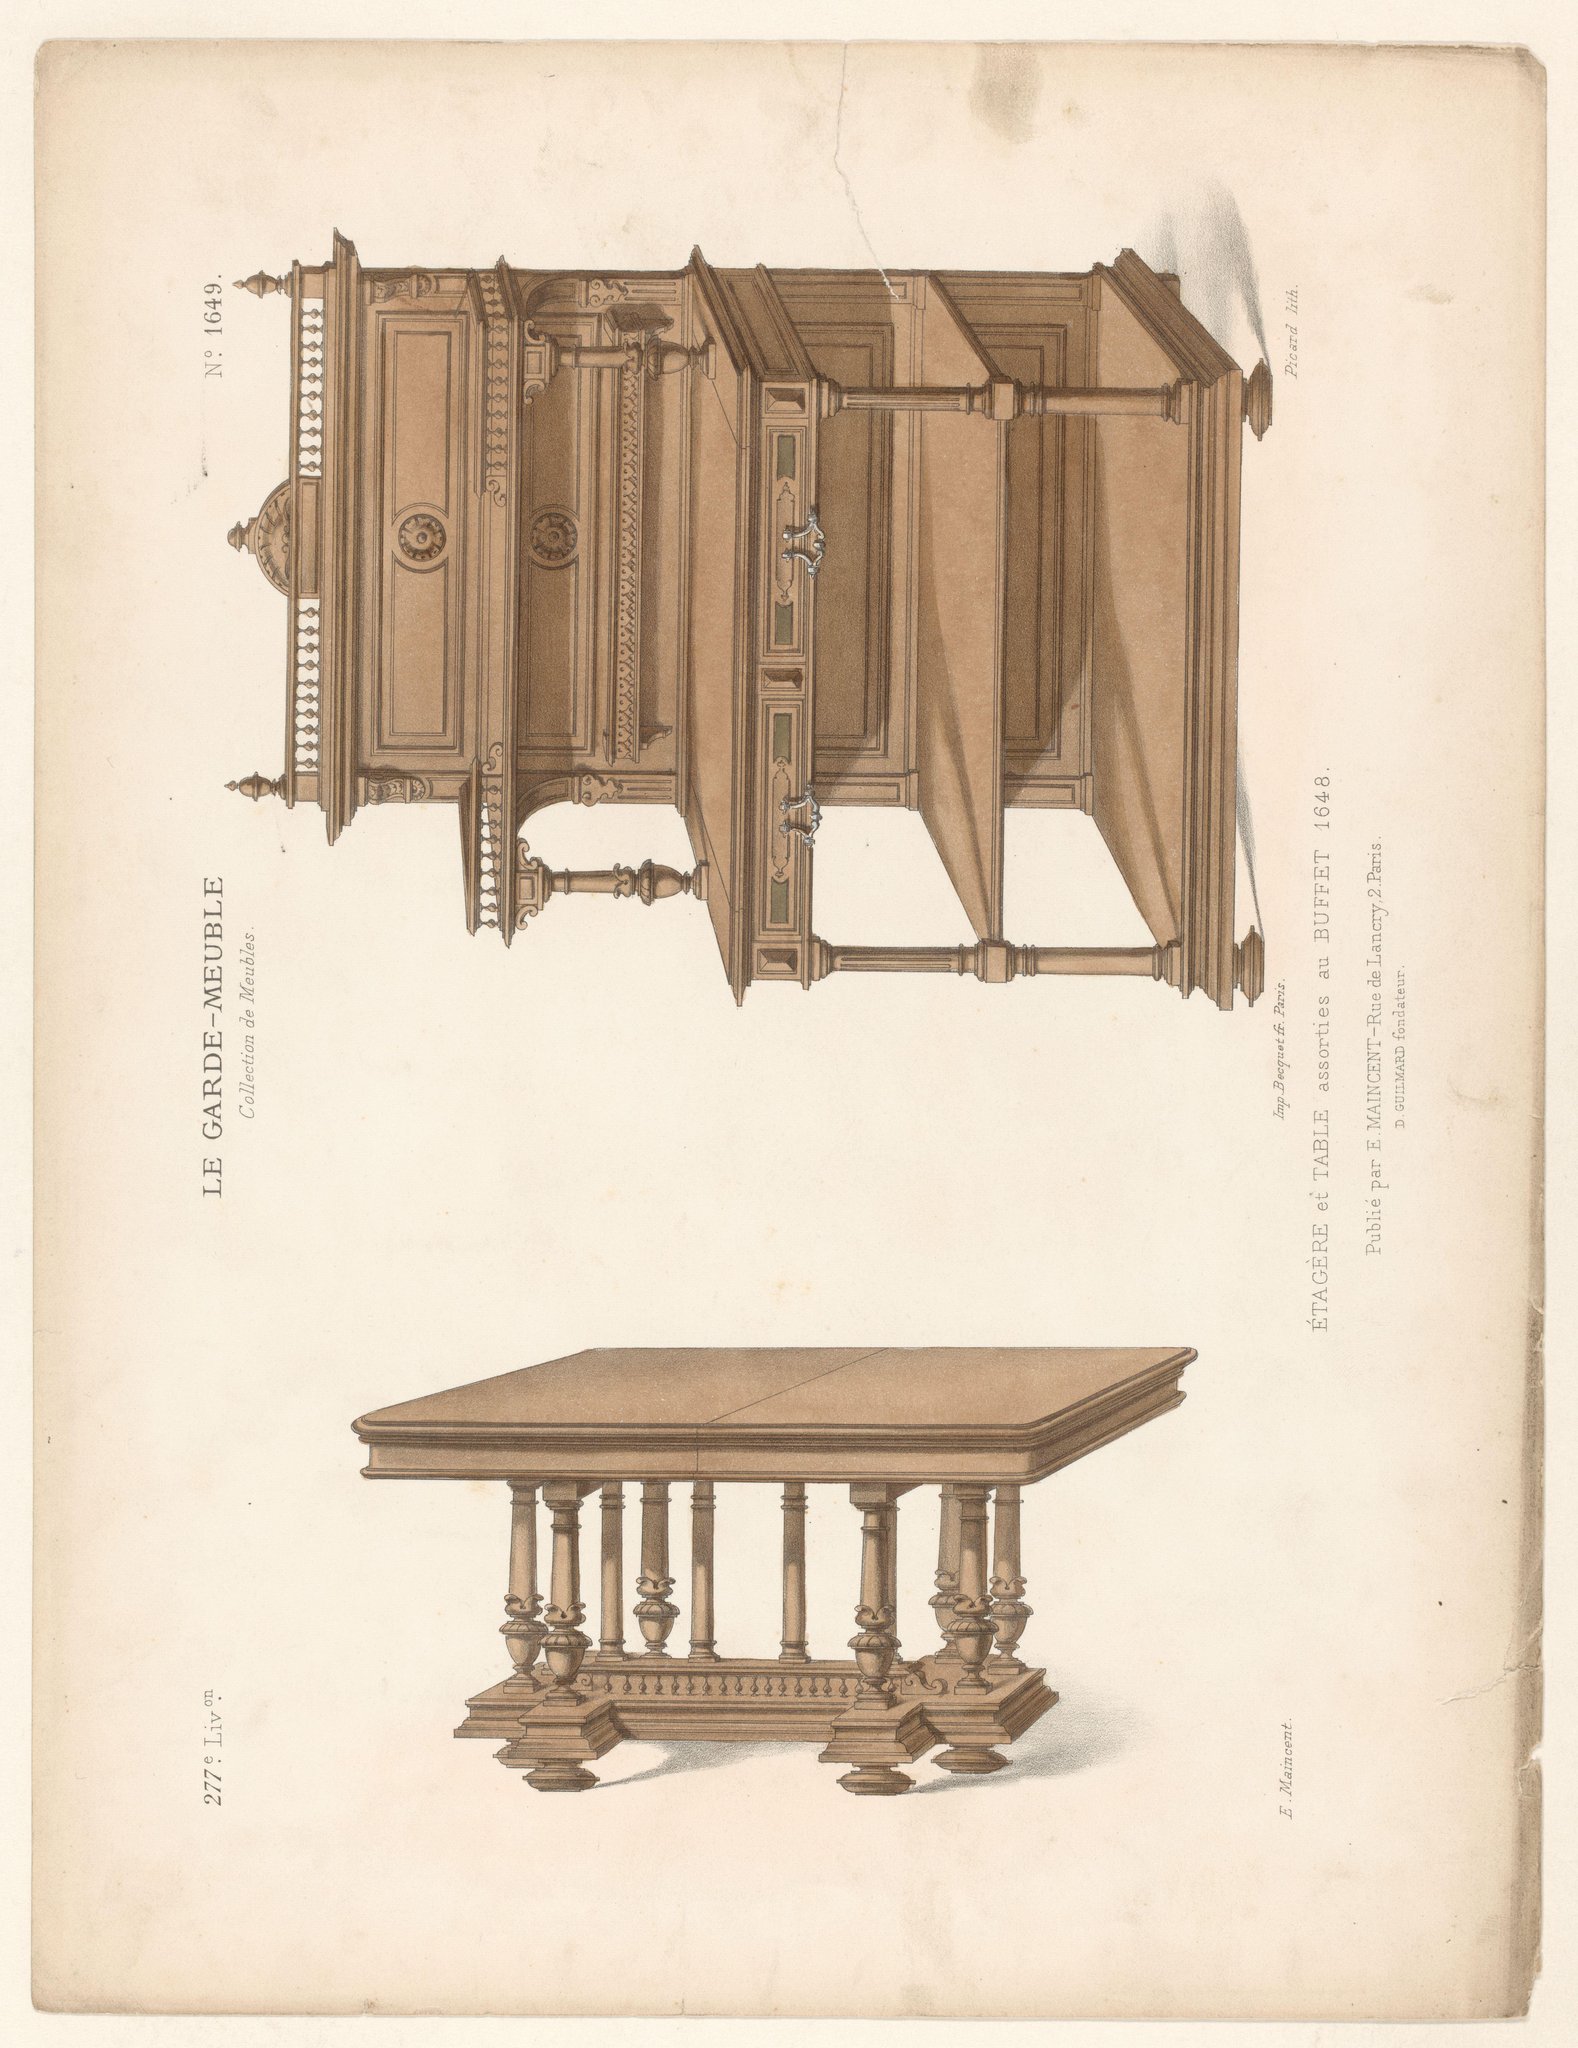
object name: print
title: Le garde-meuble / Collection de Meubles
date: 1885-1895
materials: paper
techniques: hand coloring, lithograph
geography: paris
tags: furniture for storage, palace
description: Ieder Livraison in de serie Le Garde-Meuble bevat negen platen: drie 'sièges' (zitmeubels), drie 'meubles' (diverse meubels zoals tafels en kasten) en drie 'tentures' (gordijnen en draperieën).